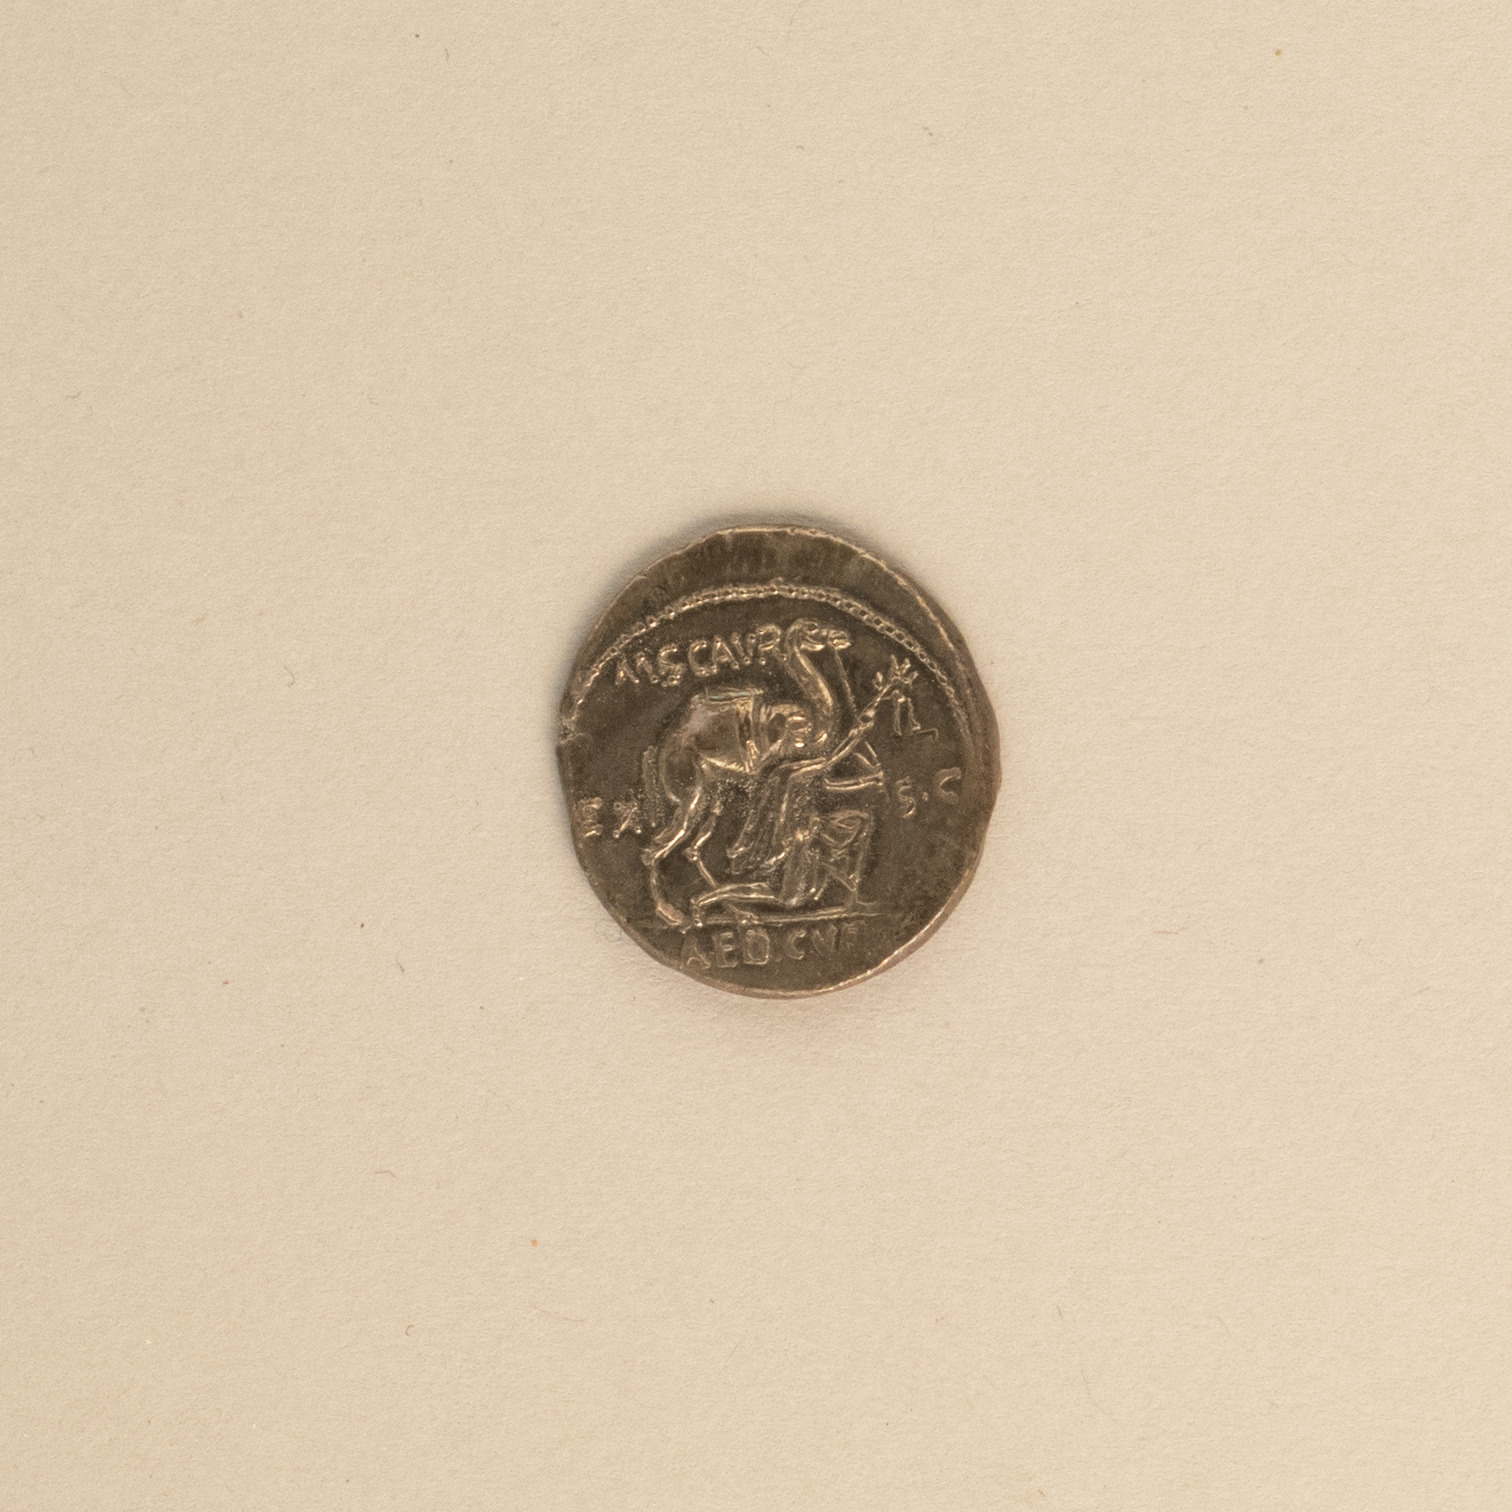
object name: denarius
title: Silver denarius of Aemilius Scaurus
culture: roman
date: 58 BCE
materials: silver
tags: jupiter,camels,chariots